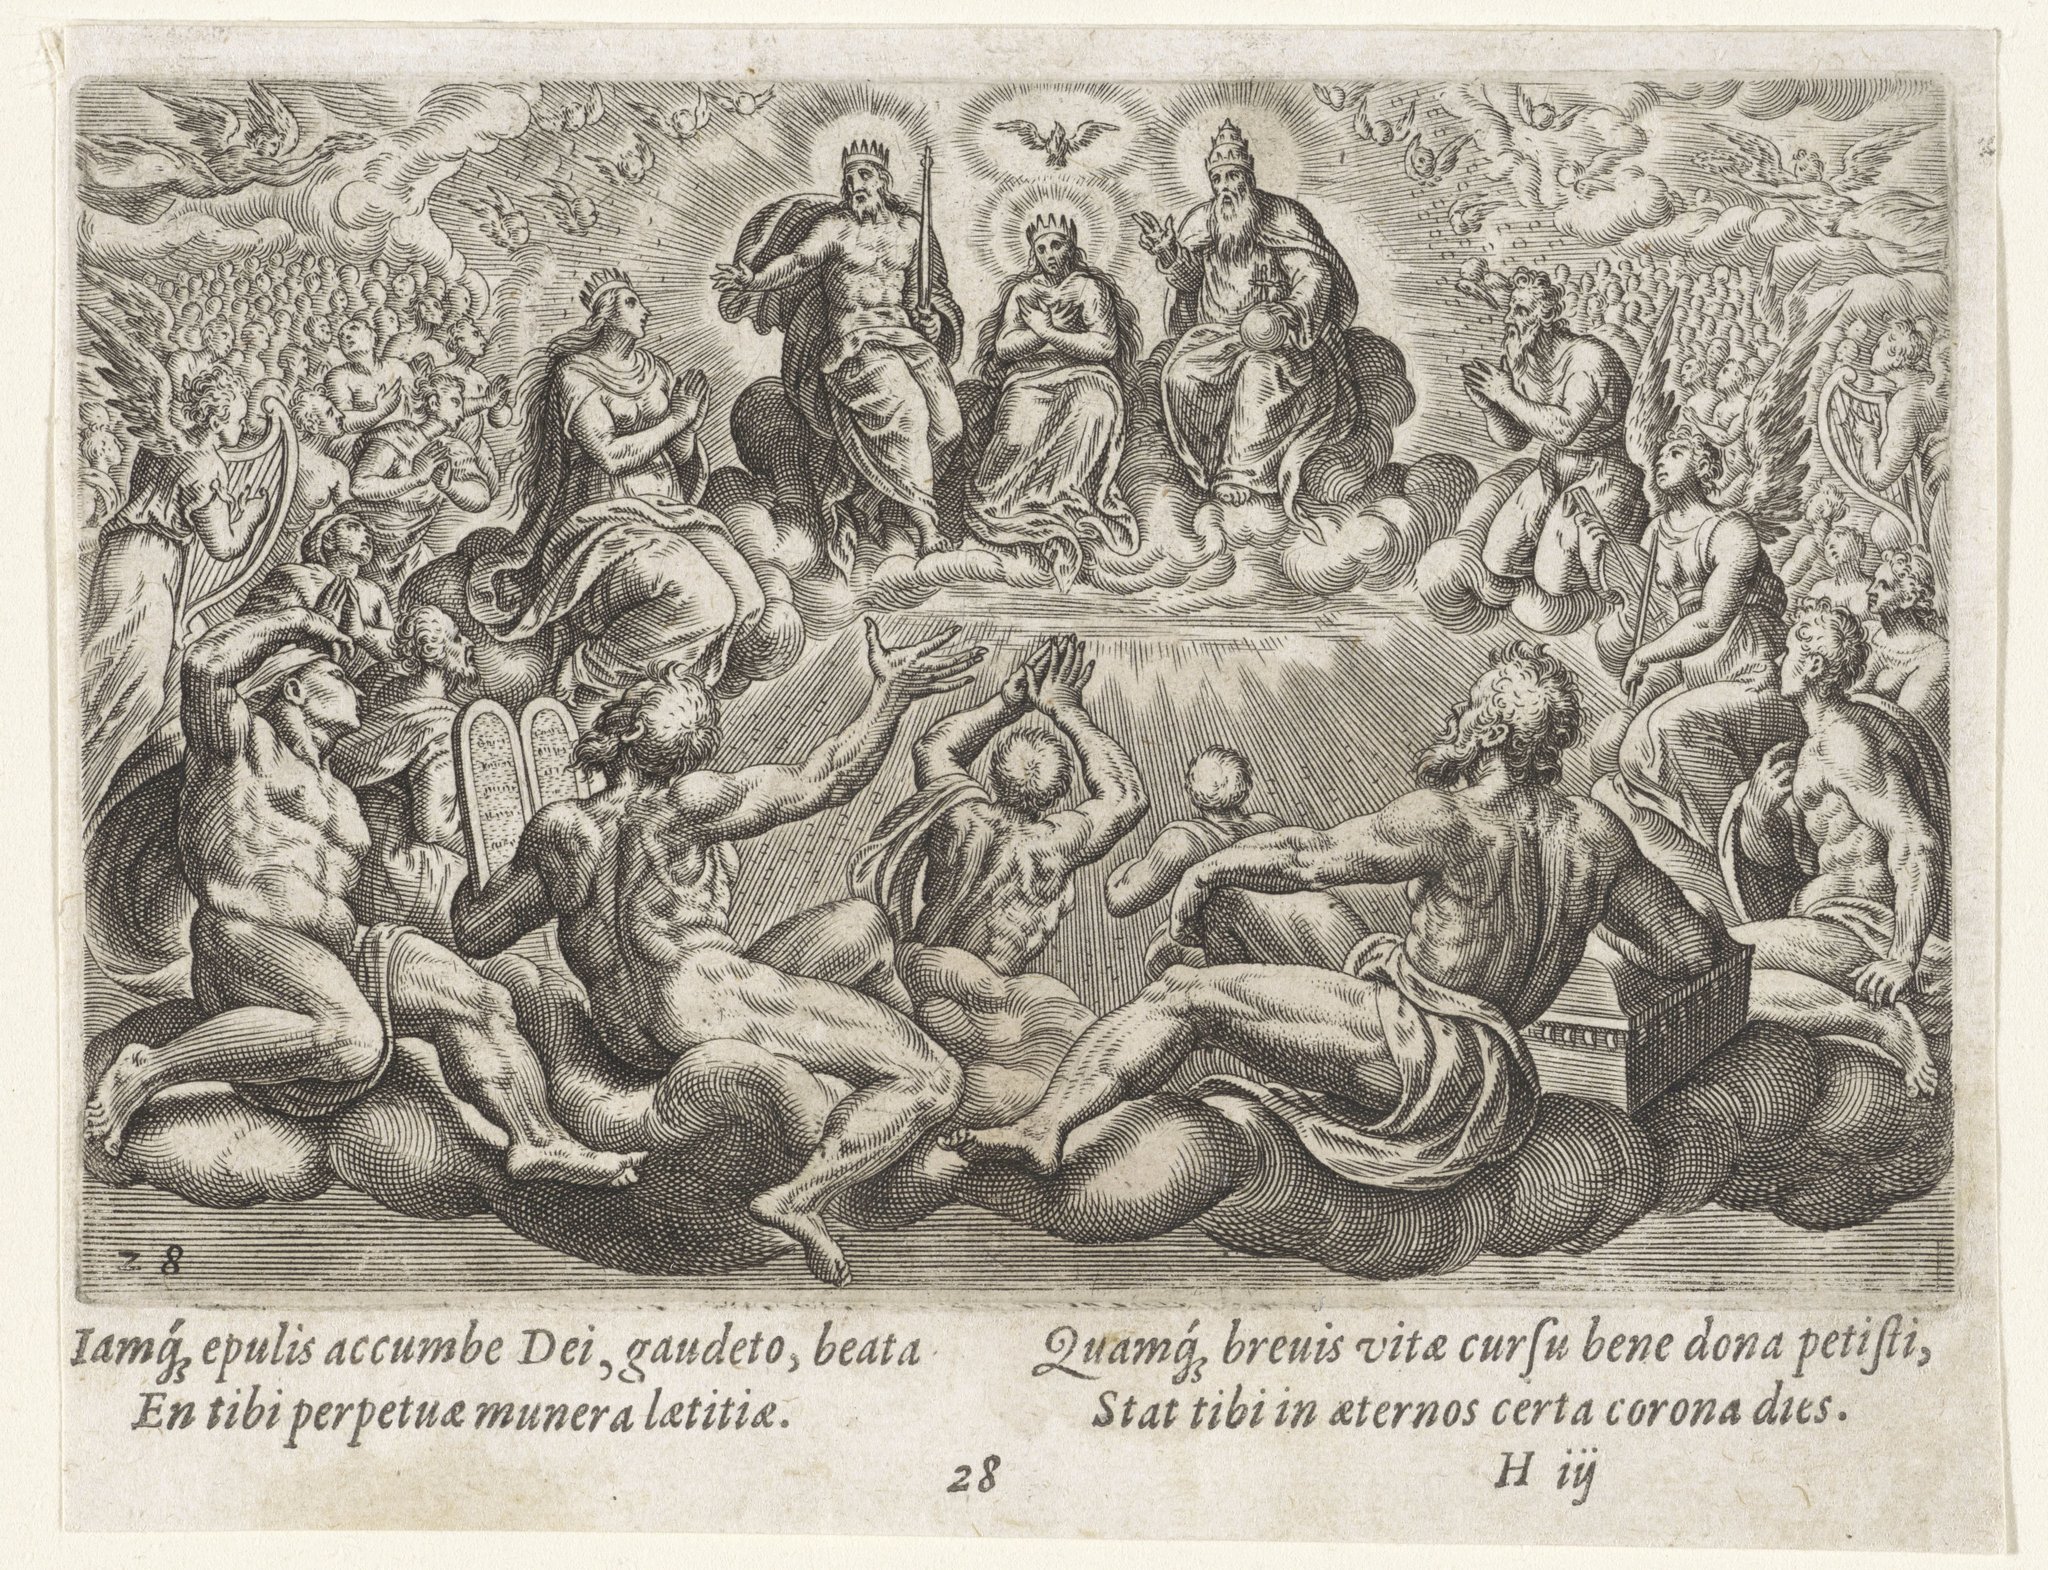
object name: print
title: Bruid in de hemel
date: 1574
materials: paper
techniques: engraving, letterpress printing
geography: antwerp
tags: trinity in which god the father and christ are represented as persons, the holy ghost as dove (+ angel(s)), (ascent into) heaven, bride (in wedding-dress)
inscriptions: collector's mark: Lugt 2228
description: De bruid is opgenomen in de hemel. Ze zit tussen Christus, haar bruidegom, en God de Vader. Boven haar de duif van de Heilige Geest. Oudtestamentische figuren en engelen hebben zich in aanbidding rondom hen geschaard. In de marge een vierregelig onderschrift, in twee kolommen, in het Latijn.